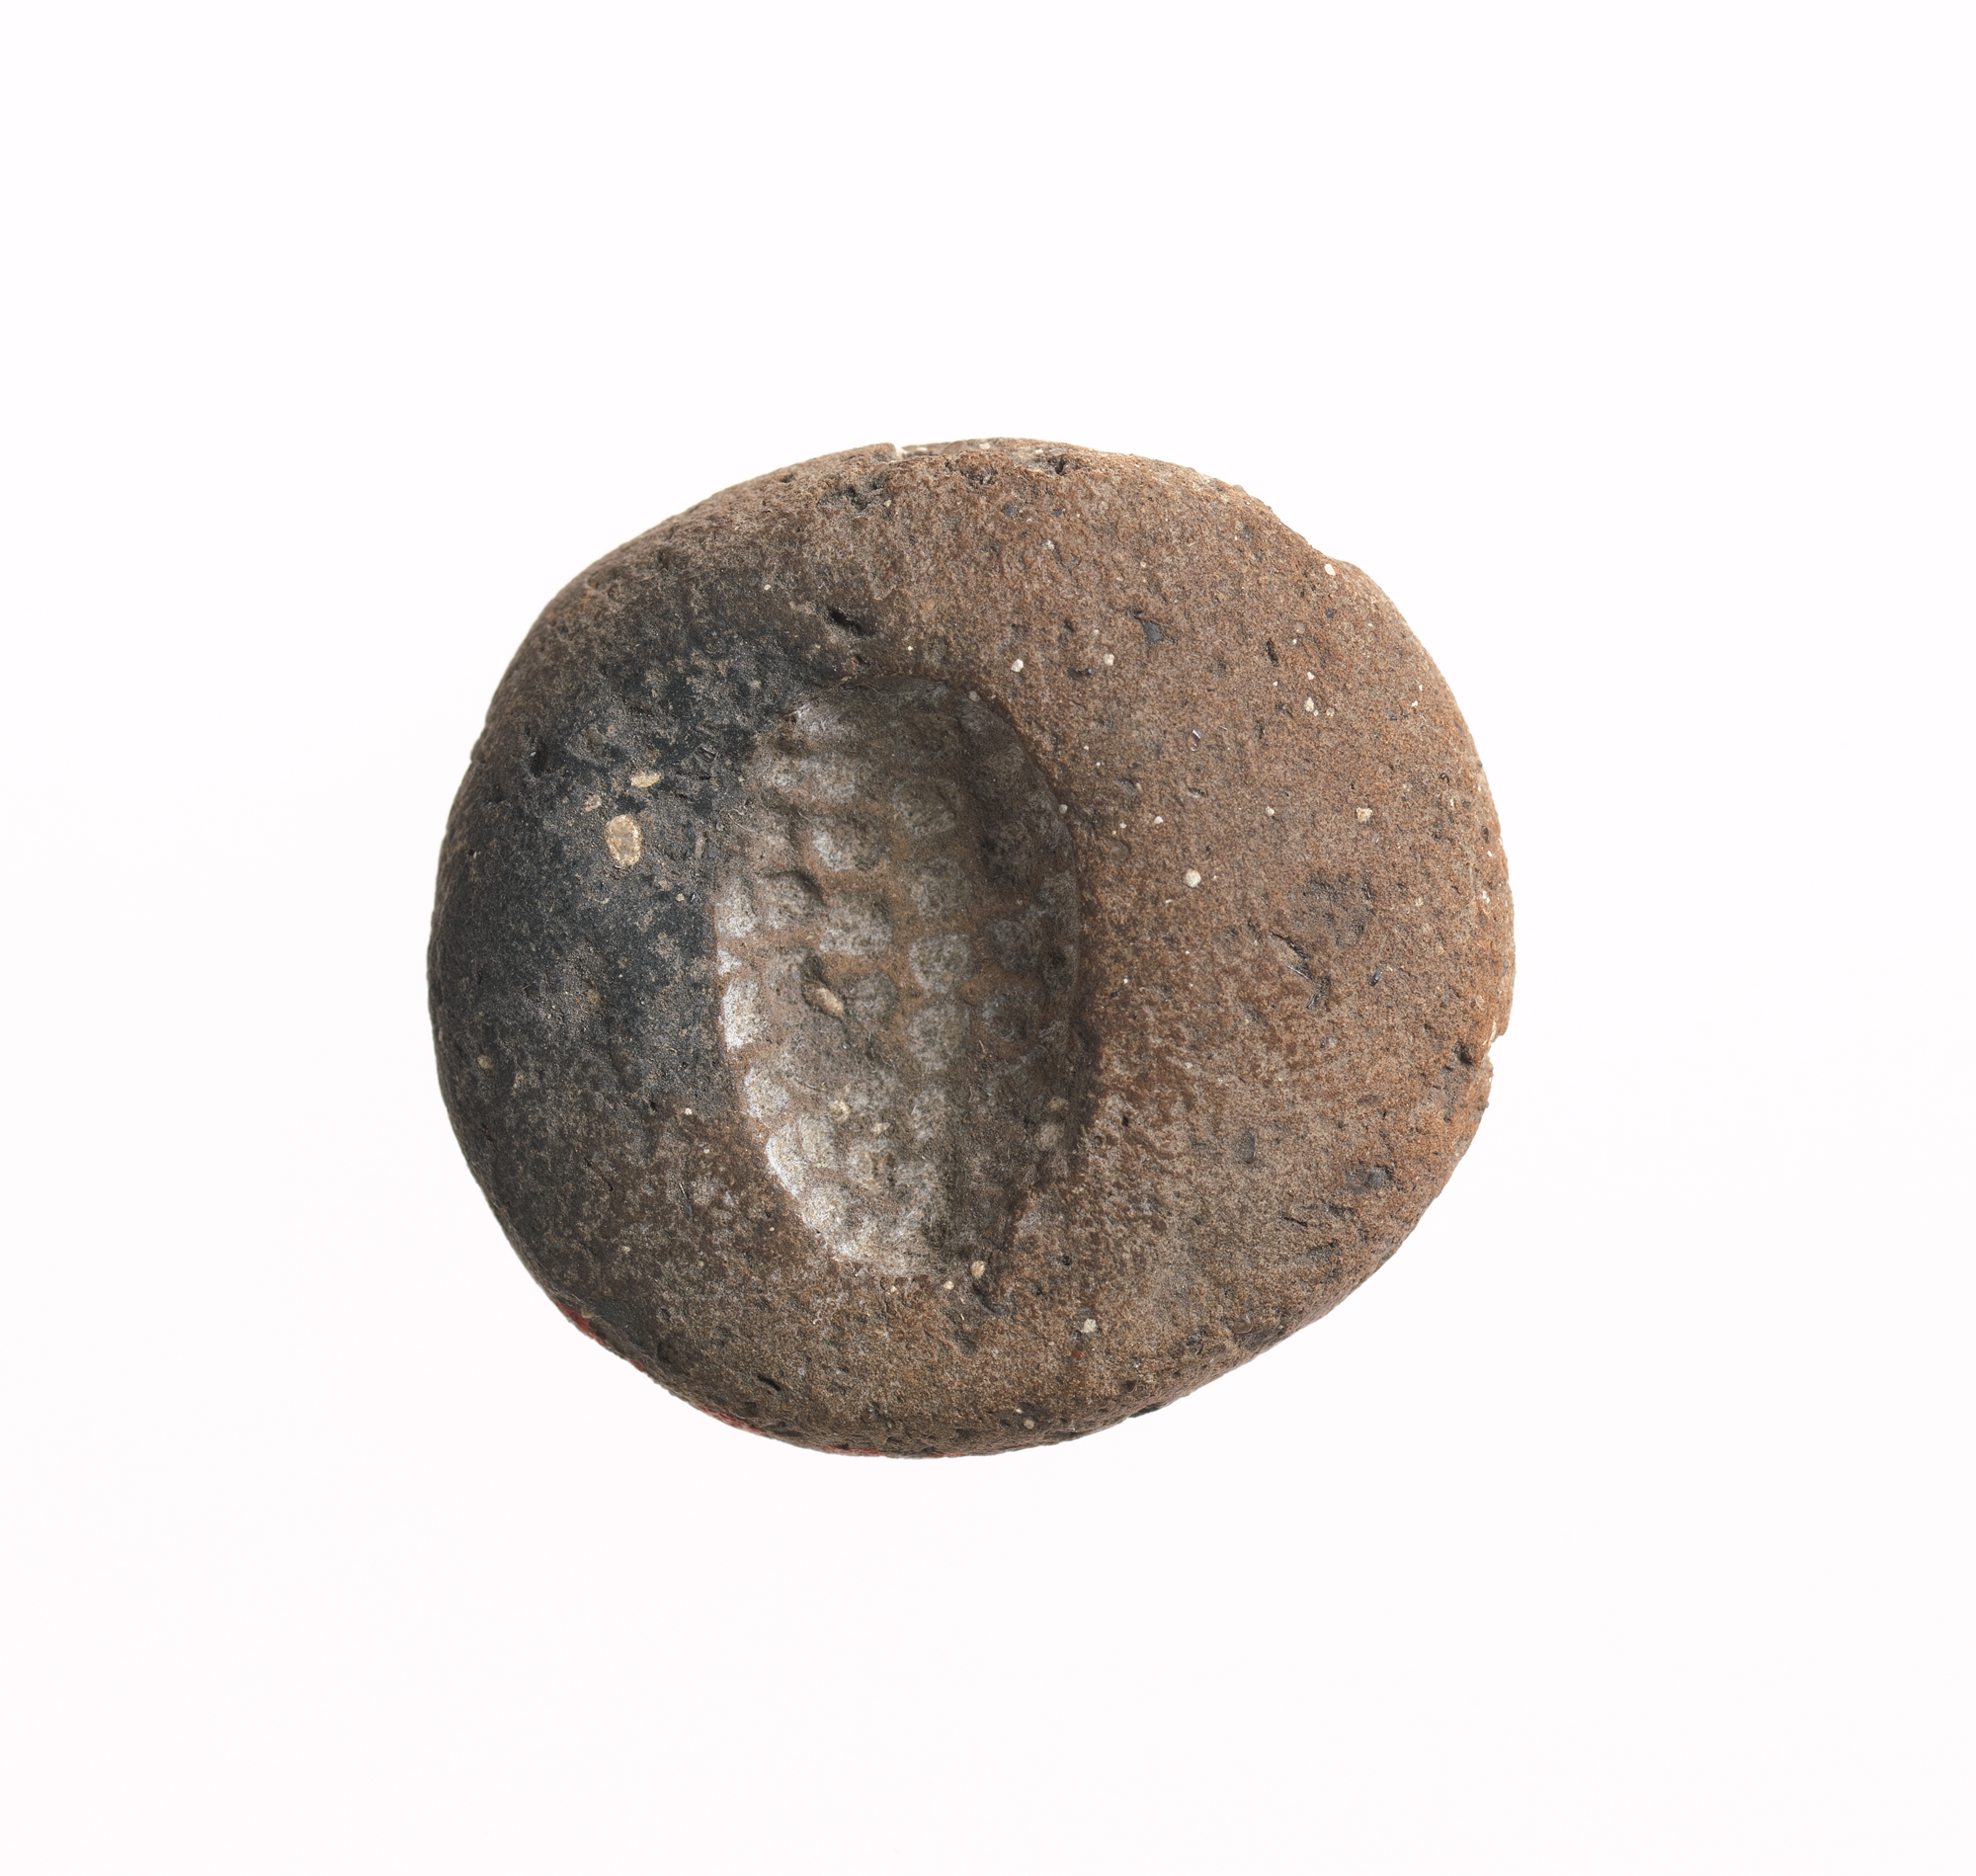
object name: mold, grape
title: Mold for a Grape Cluster Pendant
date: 1353-1336 BCE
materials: pottery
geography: egypt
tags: grapes